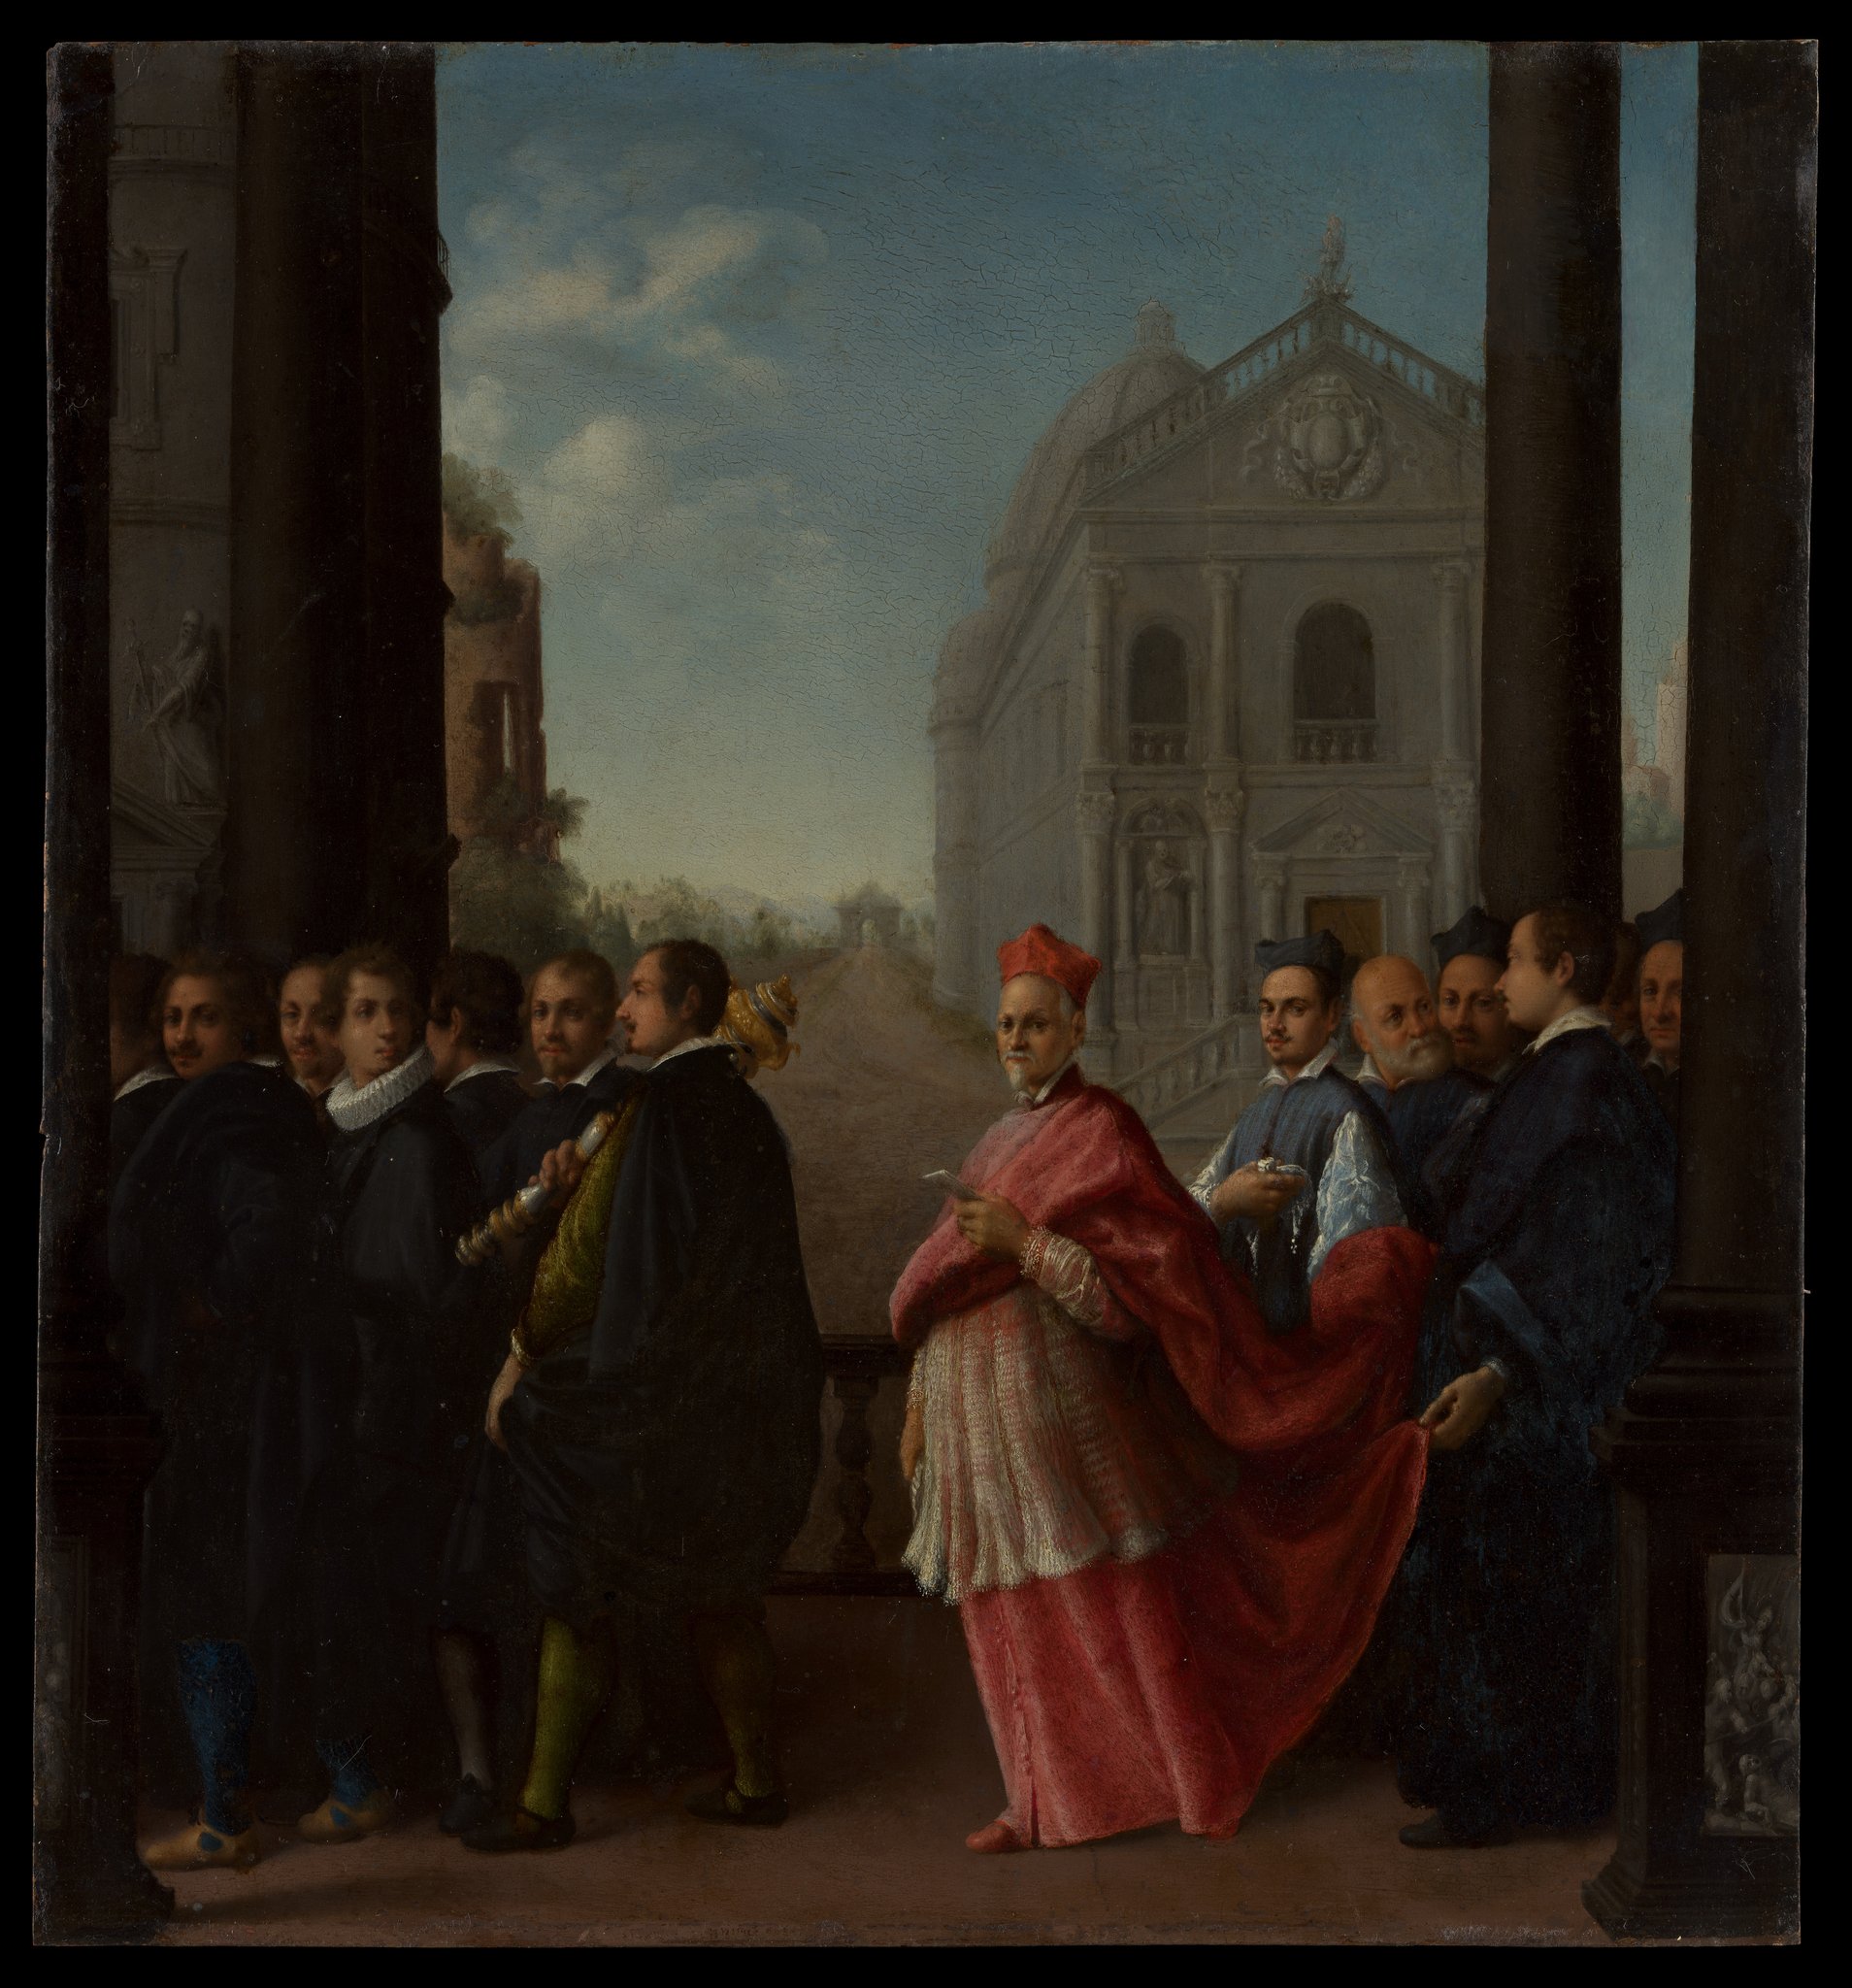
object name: painting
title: A Cardinal's Procession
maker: ottavio leoni (il padovano)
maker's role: artist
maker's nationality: italian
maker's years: 1578-1630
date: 1621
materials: copper, oil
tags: men,processions